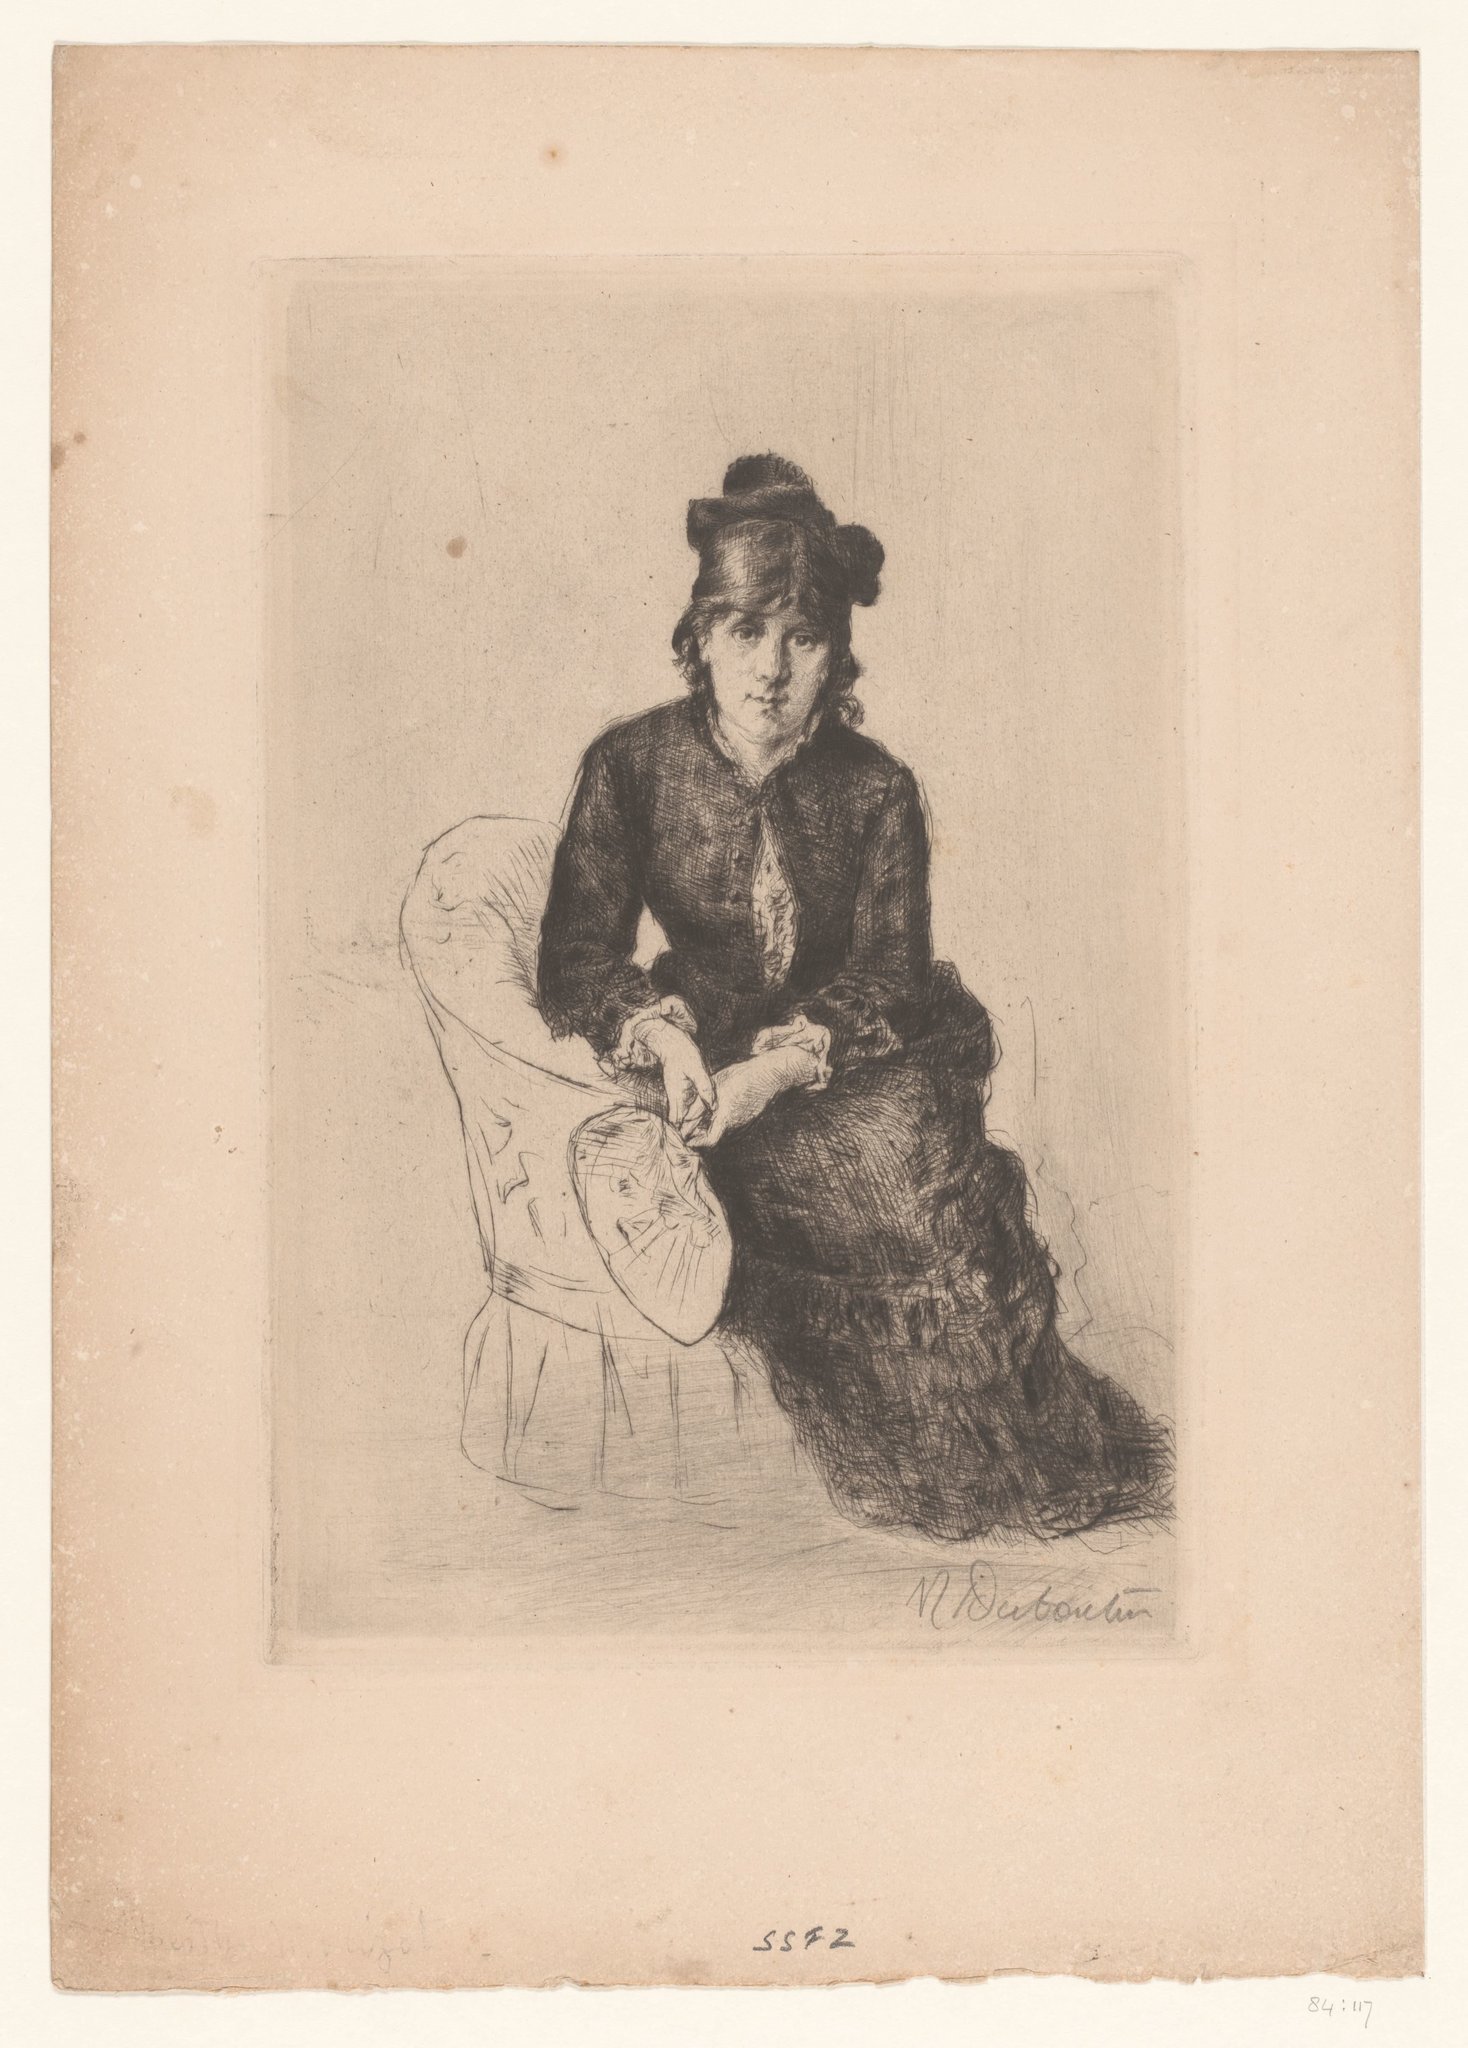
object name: print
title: Portret van Berthe Morisot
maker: marcellin gilbert desboutin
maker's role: print maker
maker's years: 1823-1902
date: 1876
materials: paper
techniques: drypoint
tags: paris, print maker, berthe morisot, historical persons, portrait, self-portrait of artist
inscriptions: collector's mark: Lugt 2760, collector's mark: Lugt 2228